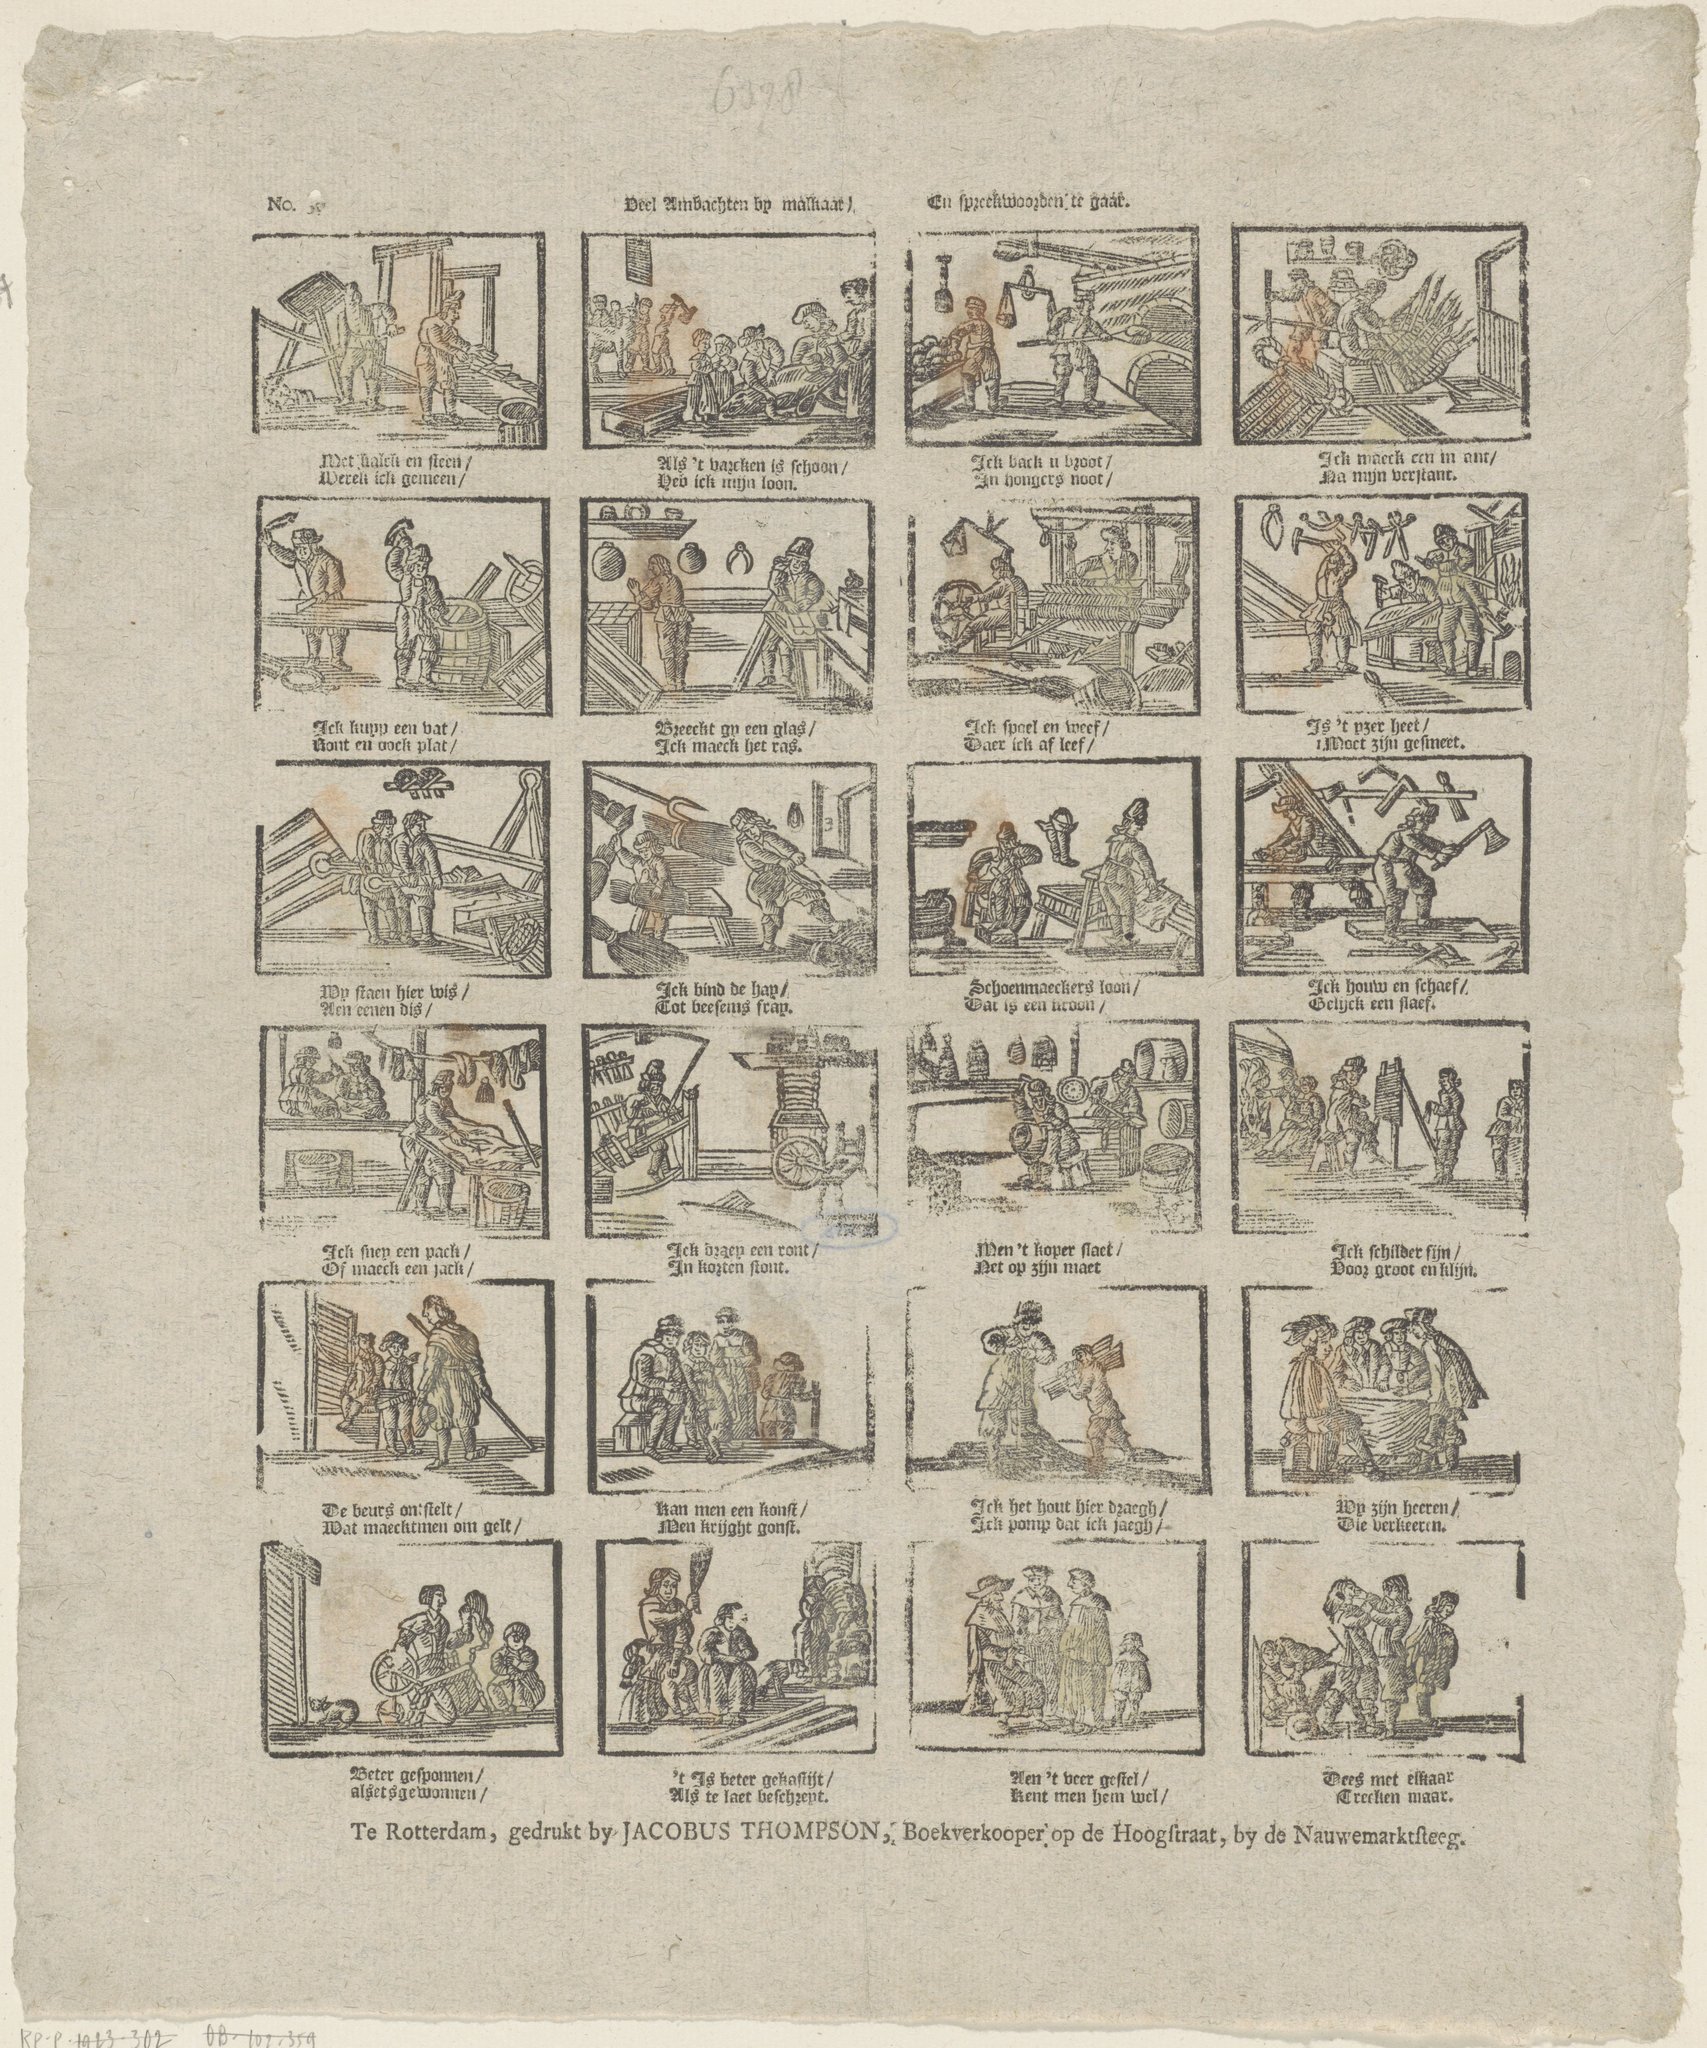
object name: popular print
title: Deel ambachten by malkaar / En spreekwoorden te gaar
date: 1791-1812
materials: paper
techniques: colour, letterpress printing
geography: netherlands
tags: proverbs, sayings, etc., crafts and industries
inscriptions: collector's mark: Lugt 2228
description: Blad met 24 verbeeldingen van spreekwoorden en uitdrukkingen rond beroepen en ambachten. Onder elke voorstelling een tweeregelig onderschrift. Genummerd linksboven: No. 57.